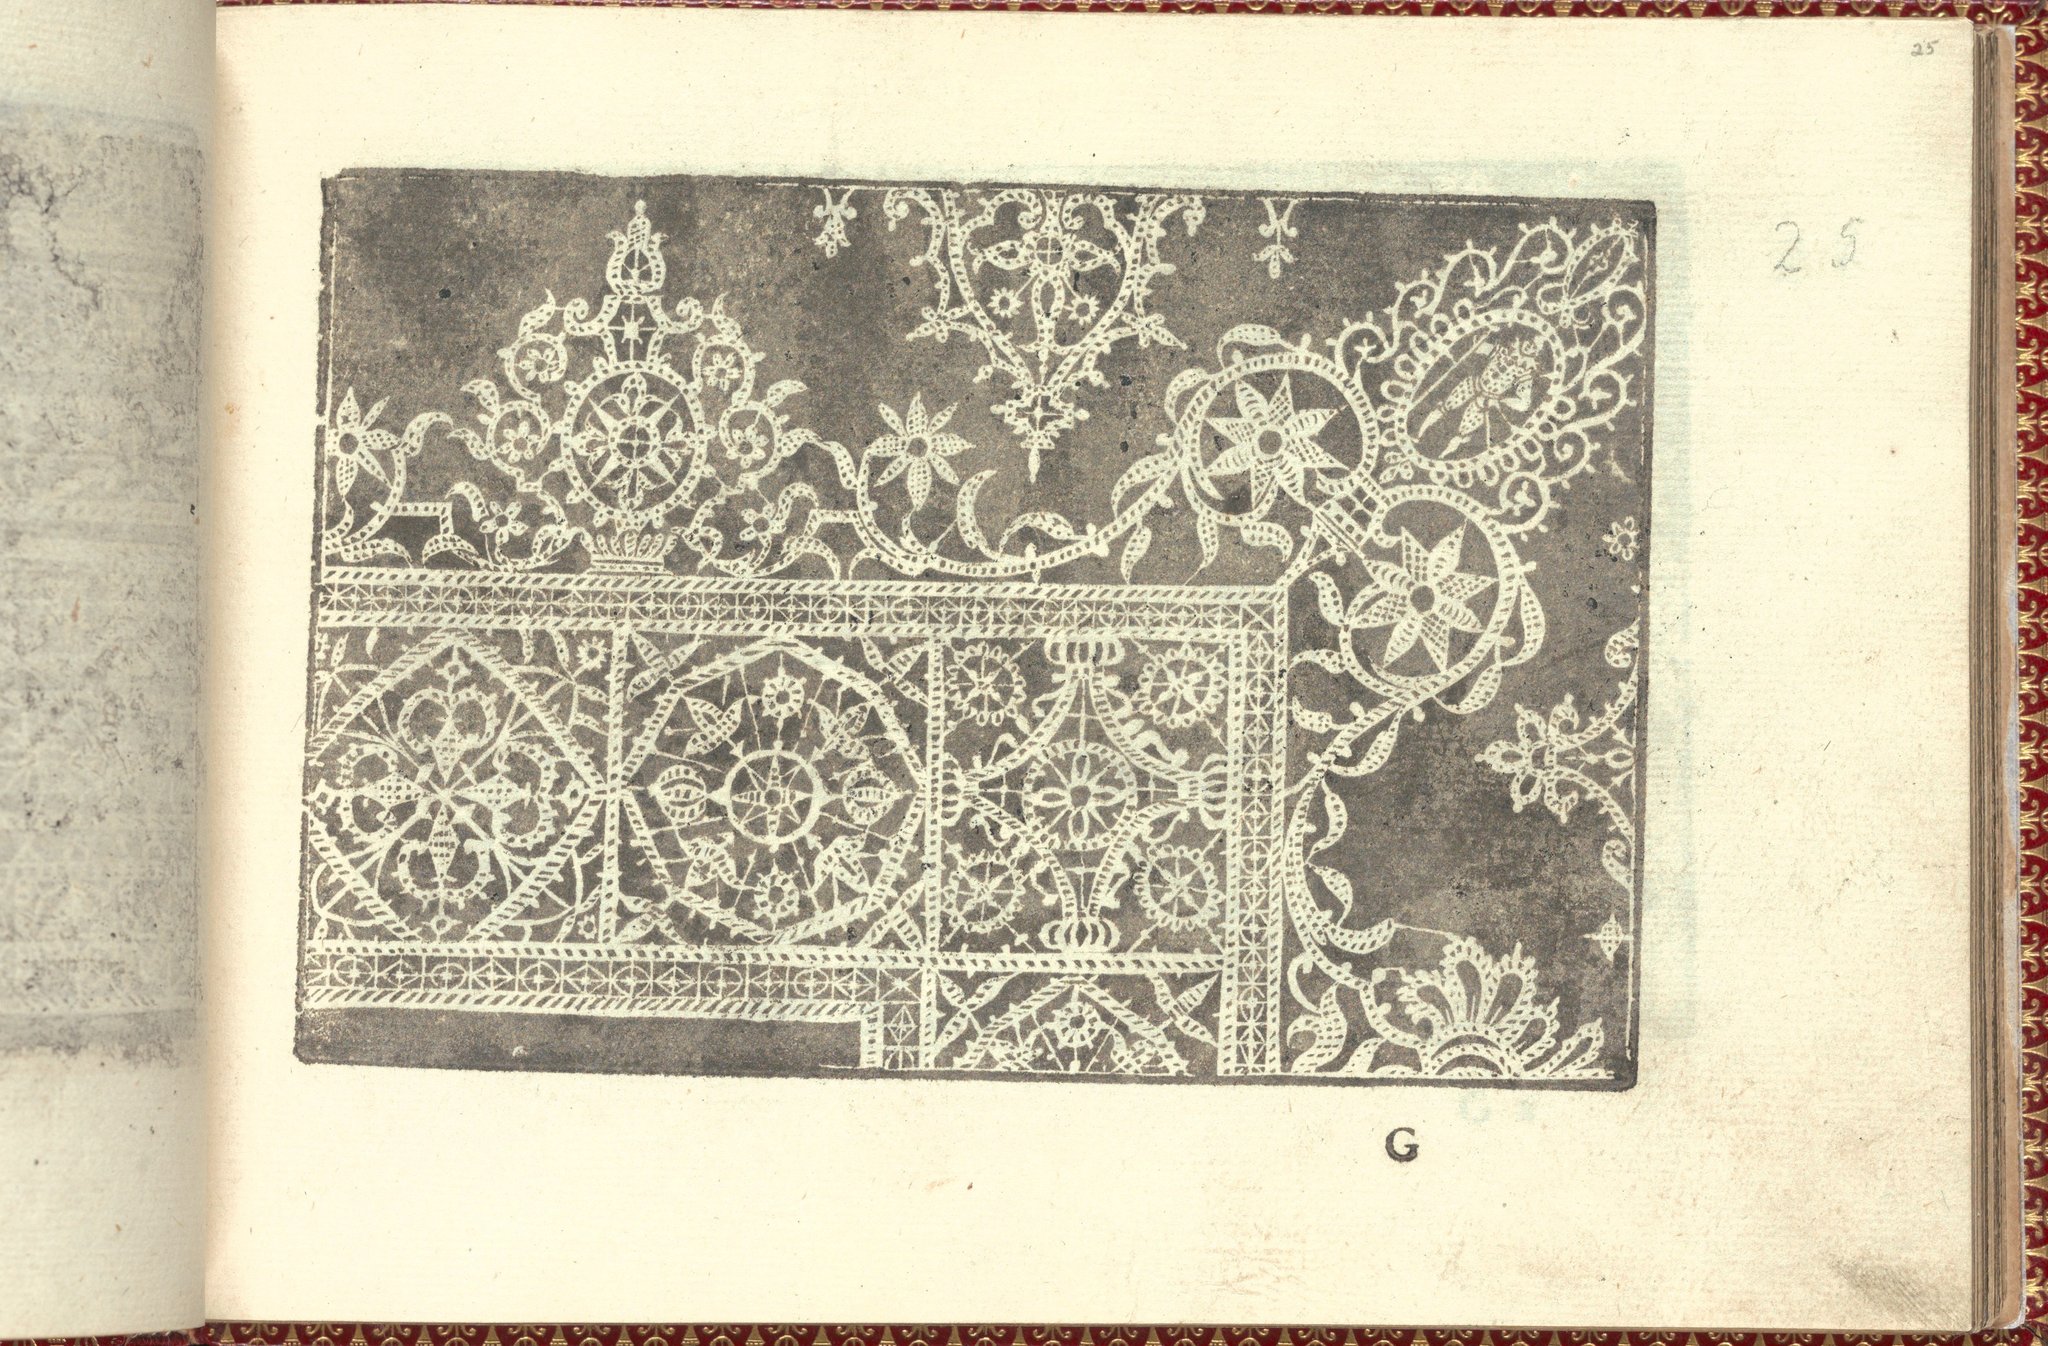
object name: book print ornament architecture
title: Corona delle Nobili et Virtuose Donne: Libro I-IV, page 25 (recto)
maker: cesare vecellio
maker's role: publisher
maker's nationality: italian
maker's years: 1521-1601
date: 1601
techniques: woodcut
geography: italy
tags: ornament